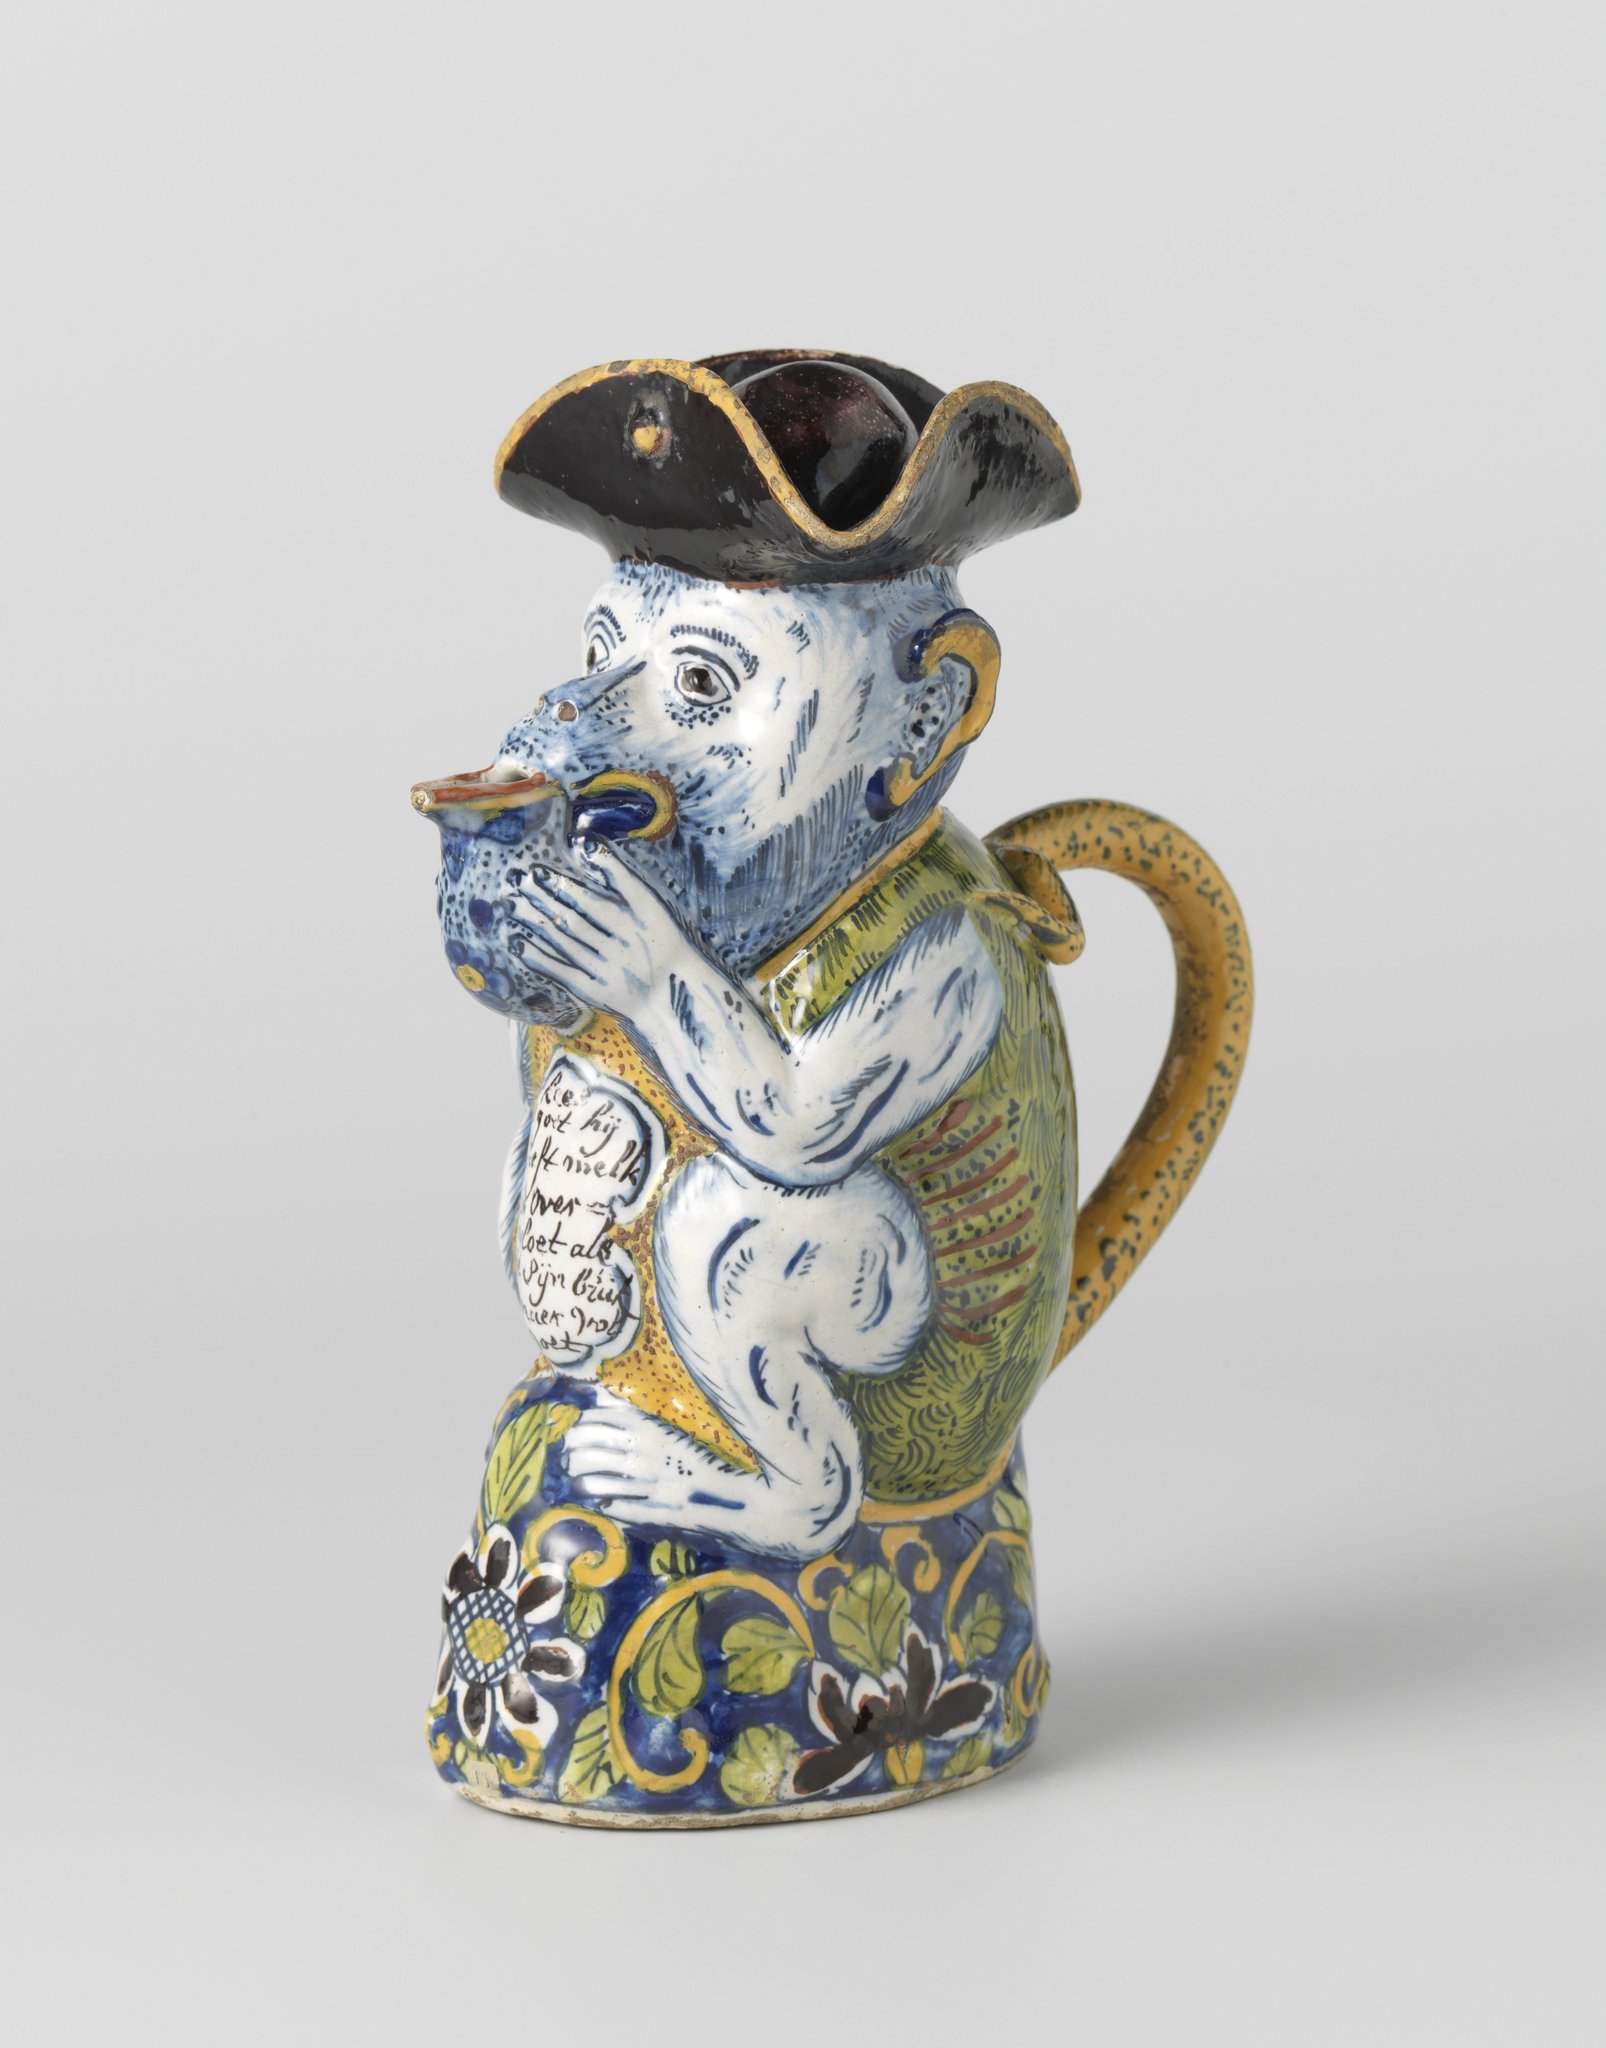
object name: milk jug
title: Milk jug in the form of a monkey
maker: Anonymous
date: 1760-1780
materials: earthenware, glaze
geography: delft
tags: head-gear: tricorn (+ men's clothes), monkeys, apes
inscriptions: inscription: ‘Kees/ is goet/ hij geeft melk/ in over/ vloet als/ je sijn buik/ maar vol doet’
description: Melkkan van faïence, in de vorm van een drinkende aap. Op zijn buik het opschrift: kees is goet hij geeft melk in overvloet als je sijn buik maar vol doet.